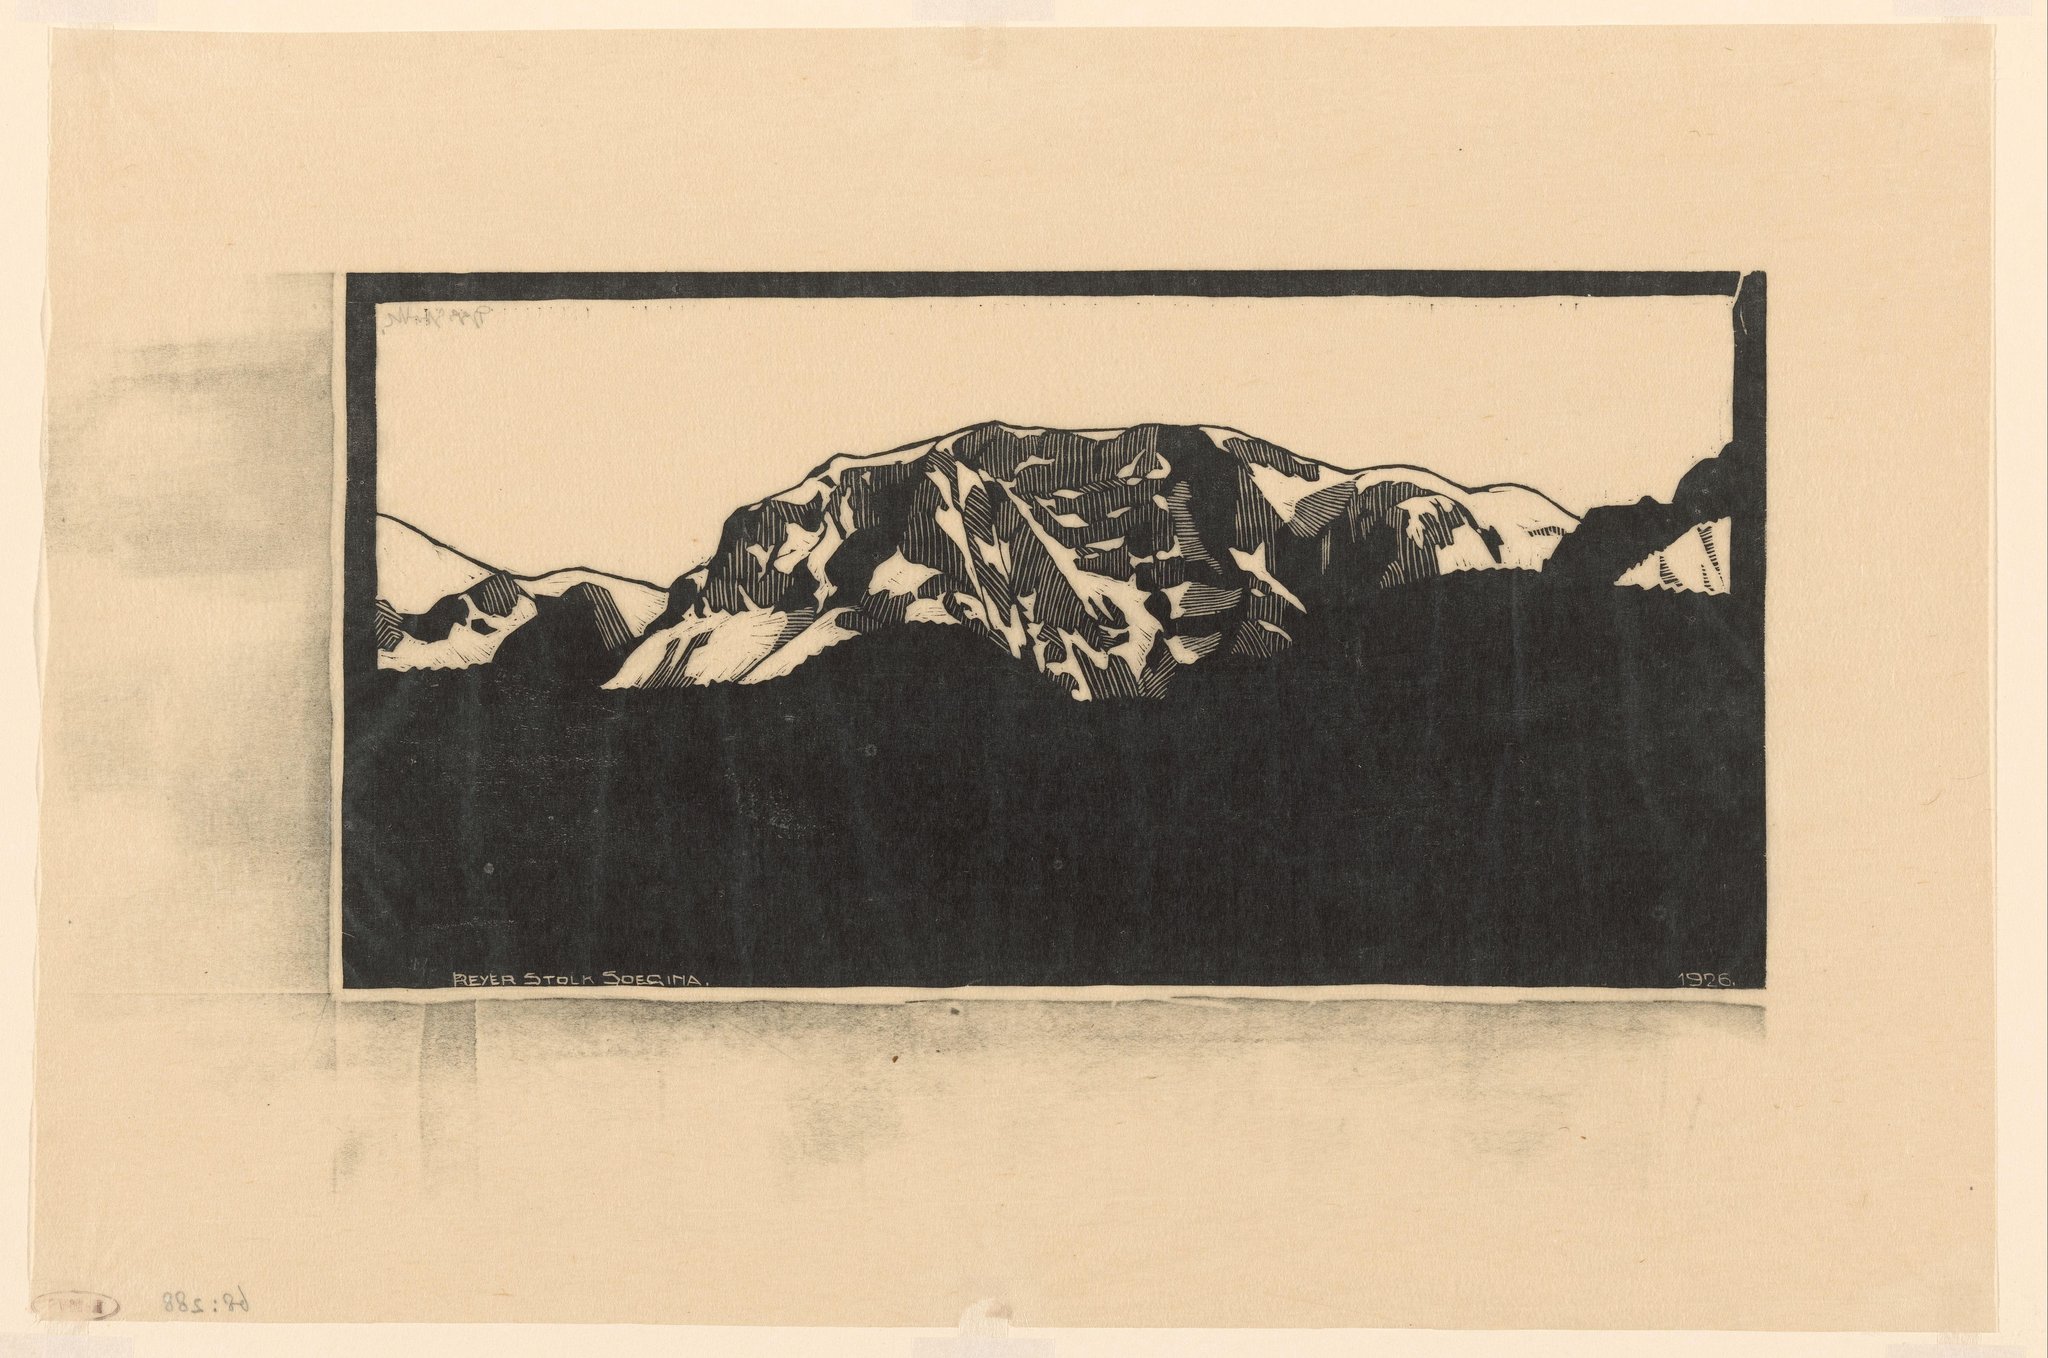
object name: print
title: Gezicht op het Höllengebergte met sneeuw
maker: reijer stolk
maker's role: draughtsman, print maker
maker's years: 1896-1945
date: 1926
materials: paper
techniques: woodcut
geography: netherlands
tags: mountain-range, snow peaks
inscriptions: collector's mark: Lugt 2228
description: Gezicht op het Höllengebergte; de toppen zijn met sneeuw bedekt.